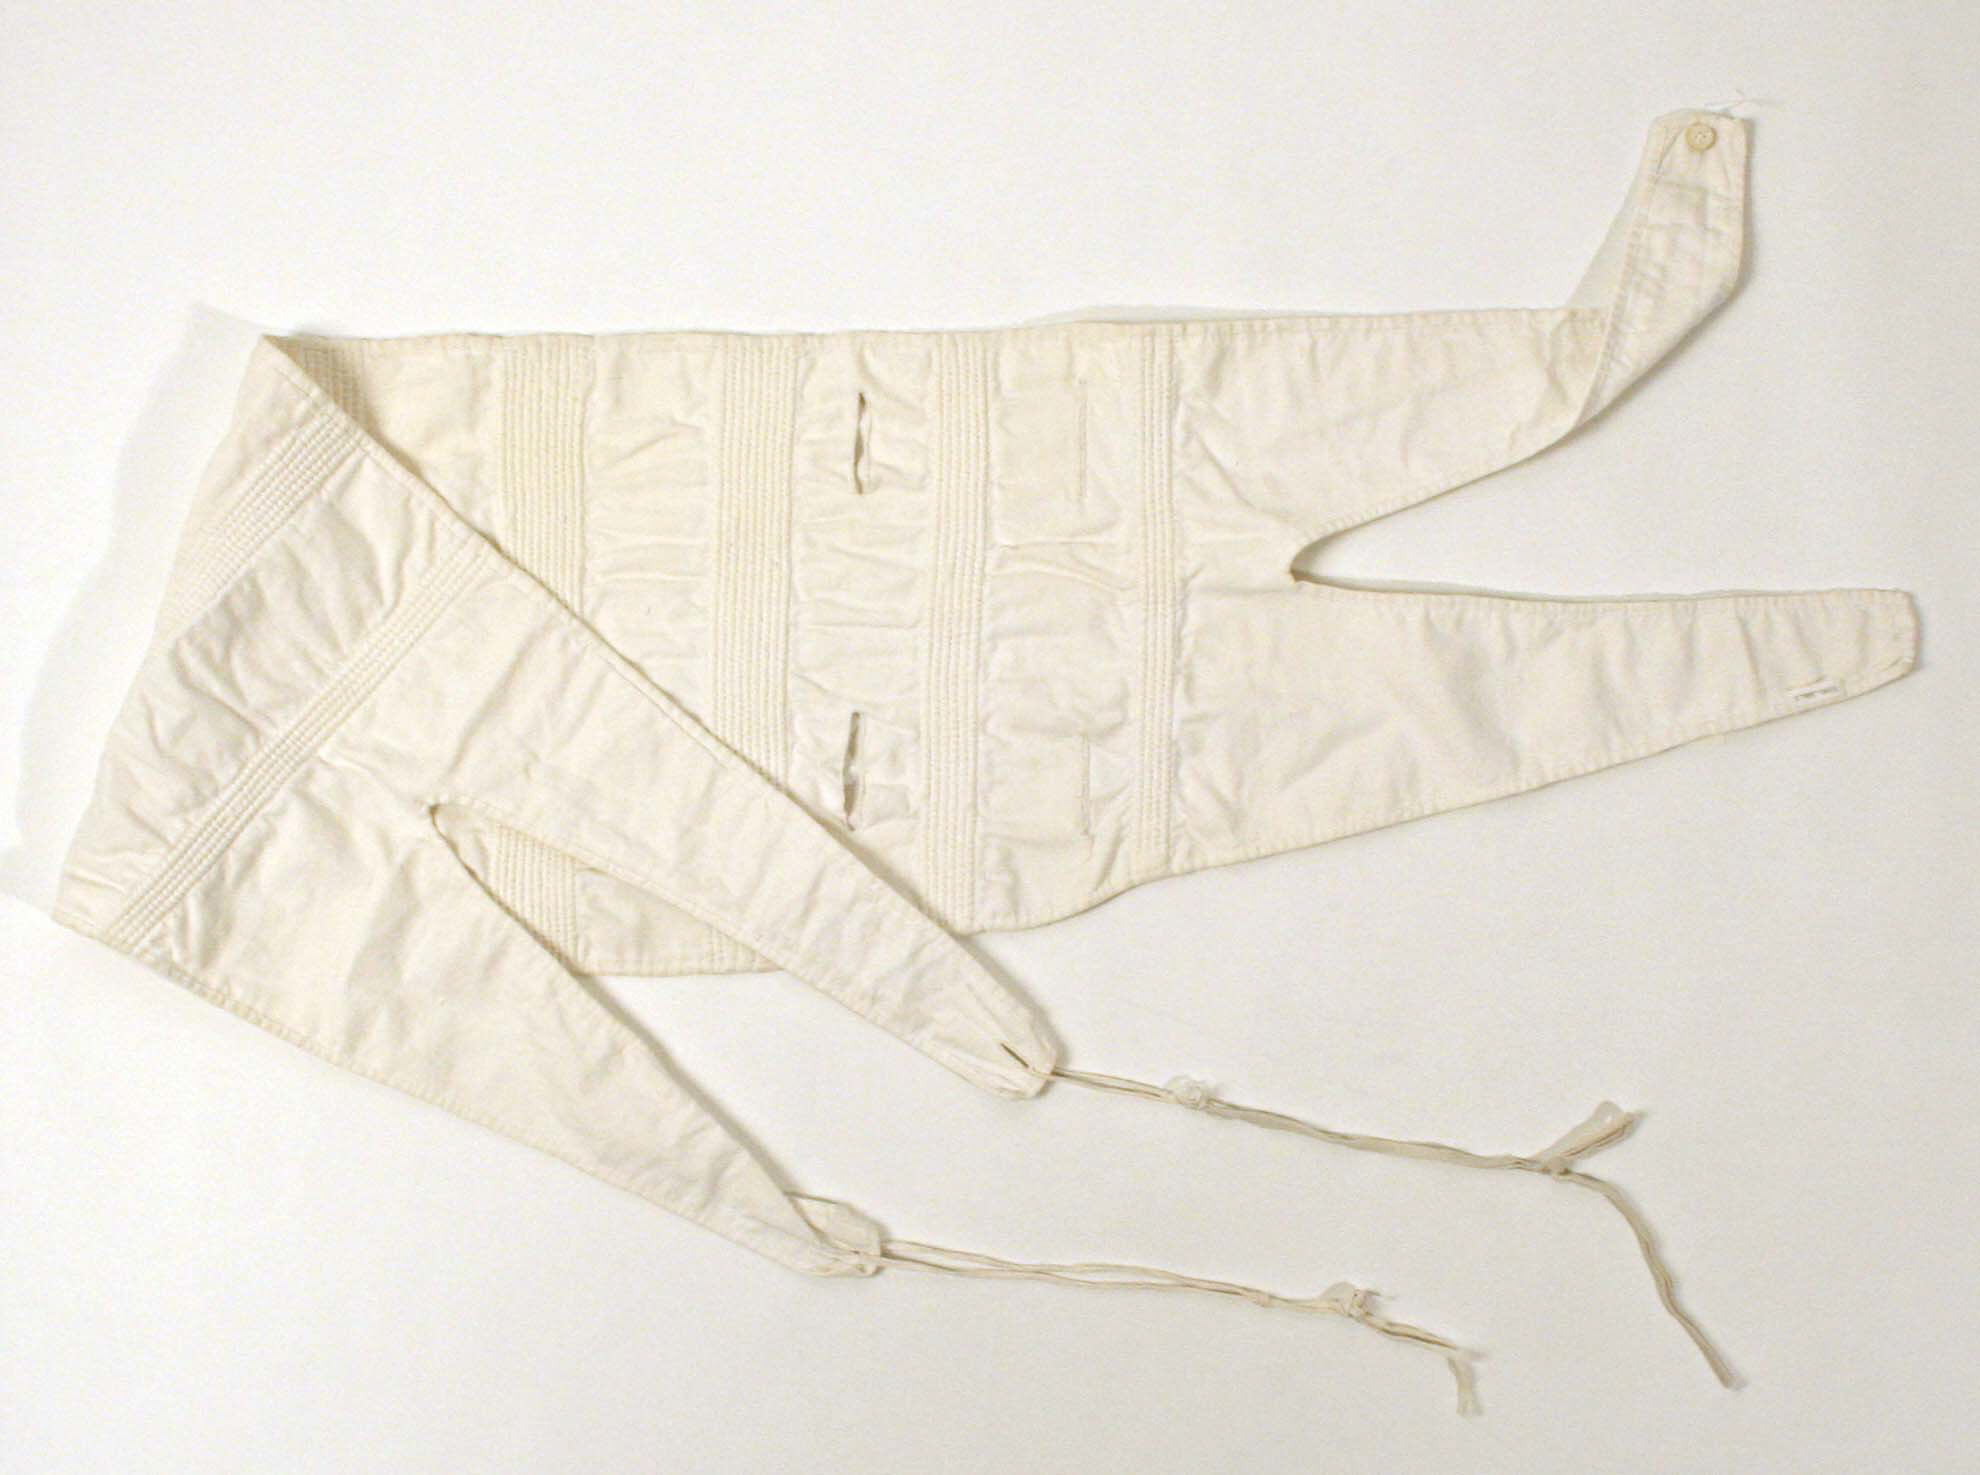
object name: corset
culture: american or european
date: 1830-1849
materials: cotton